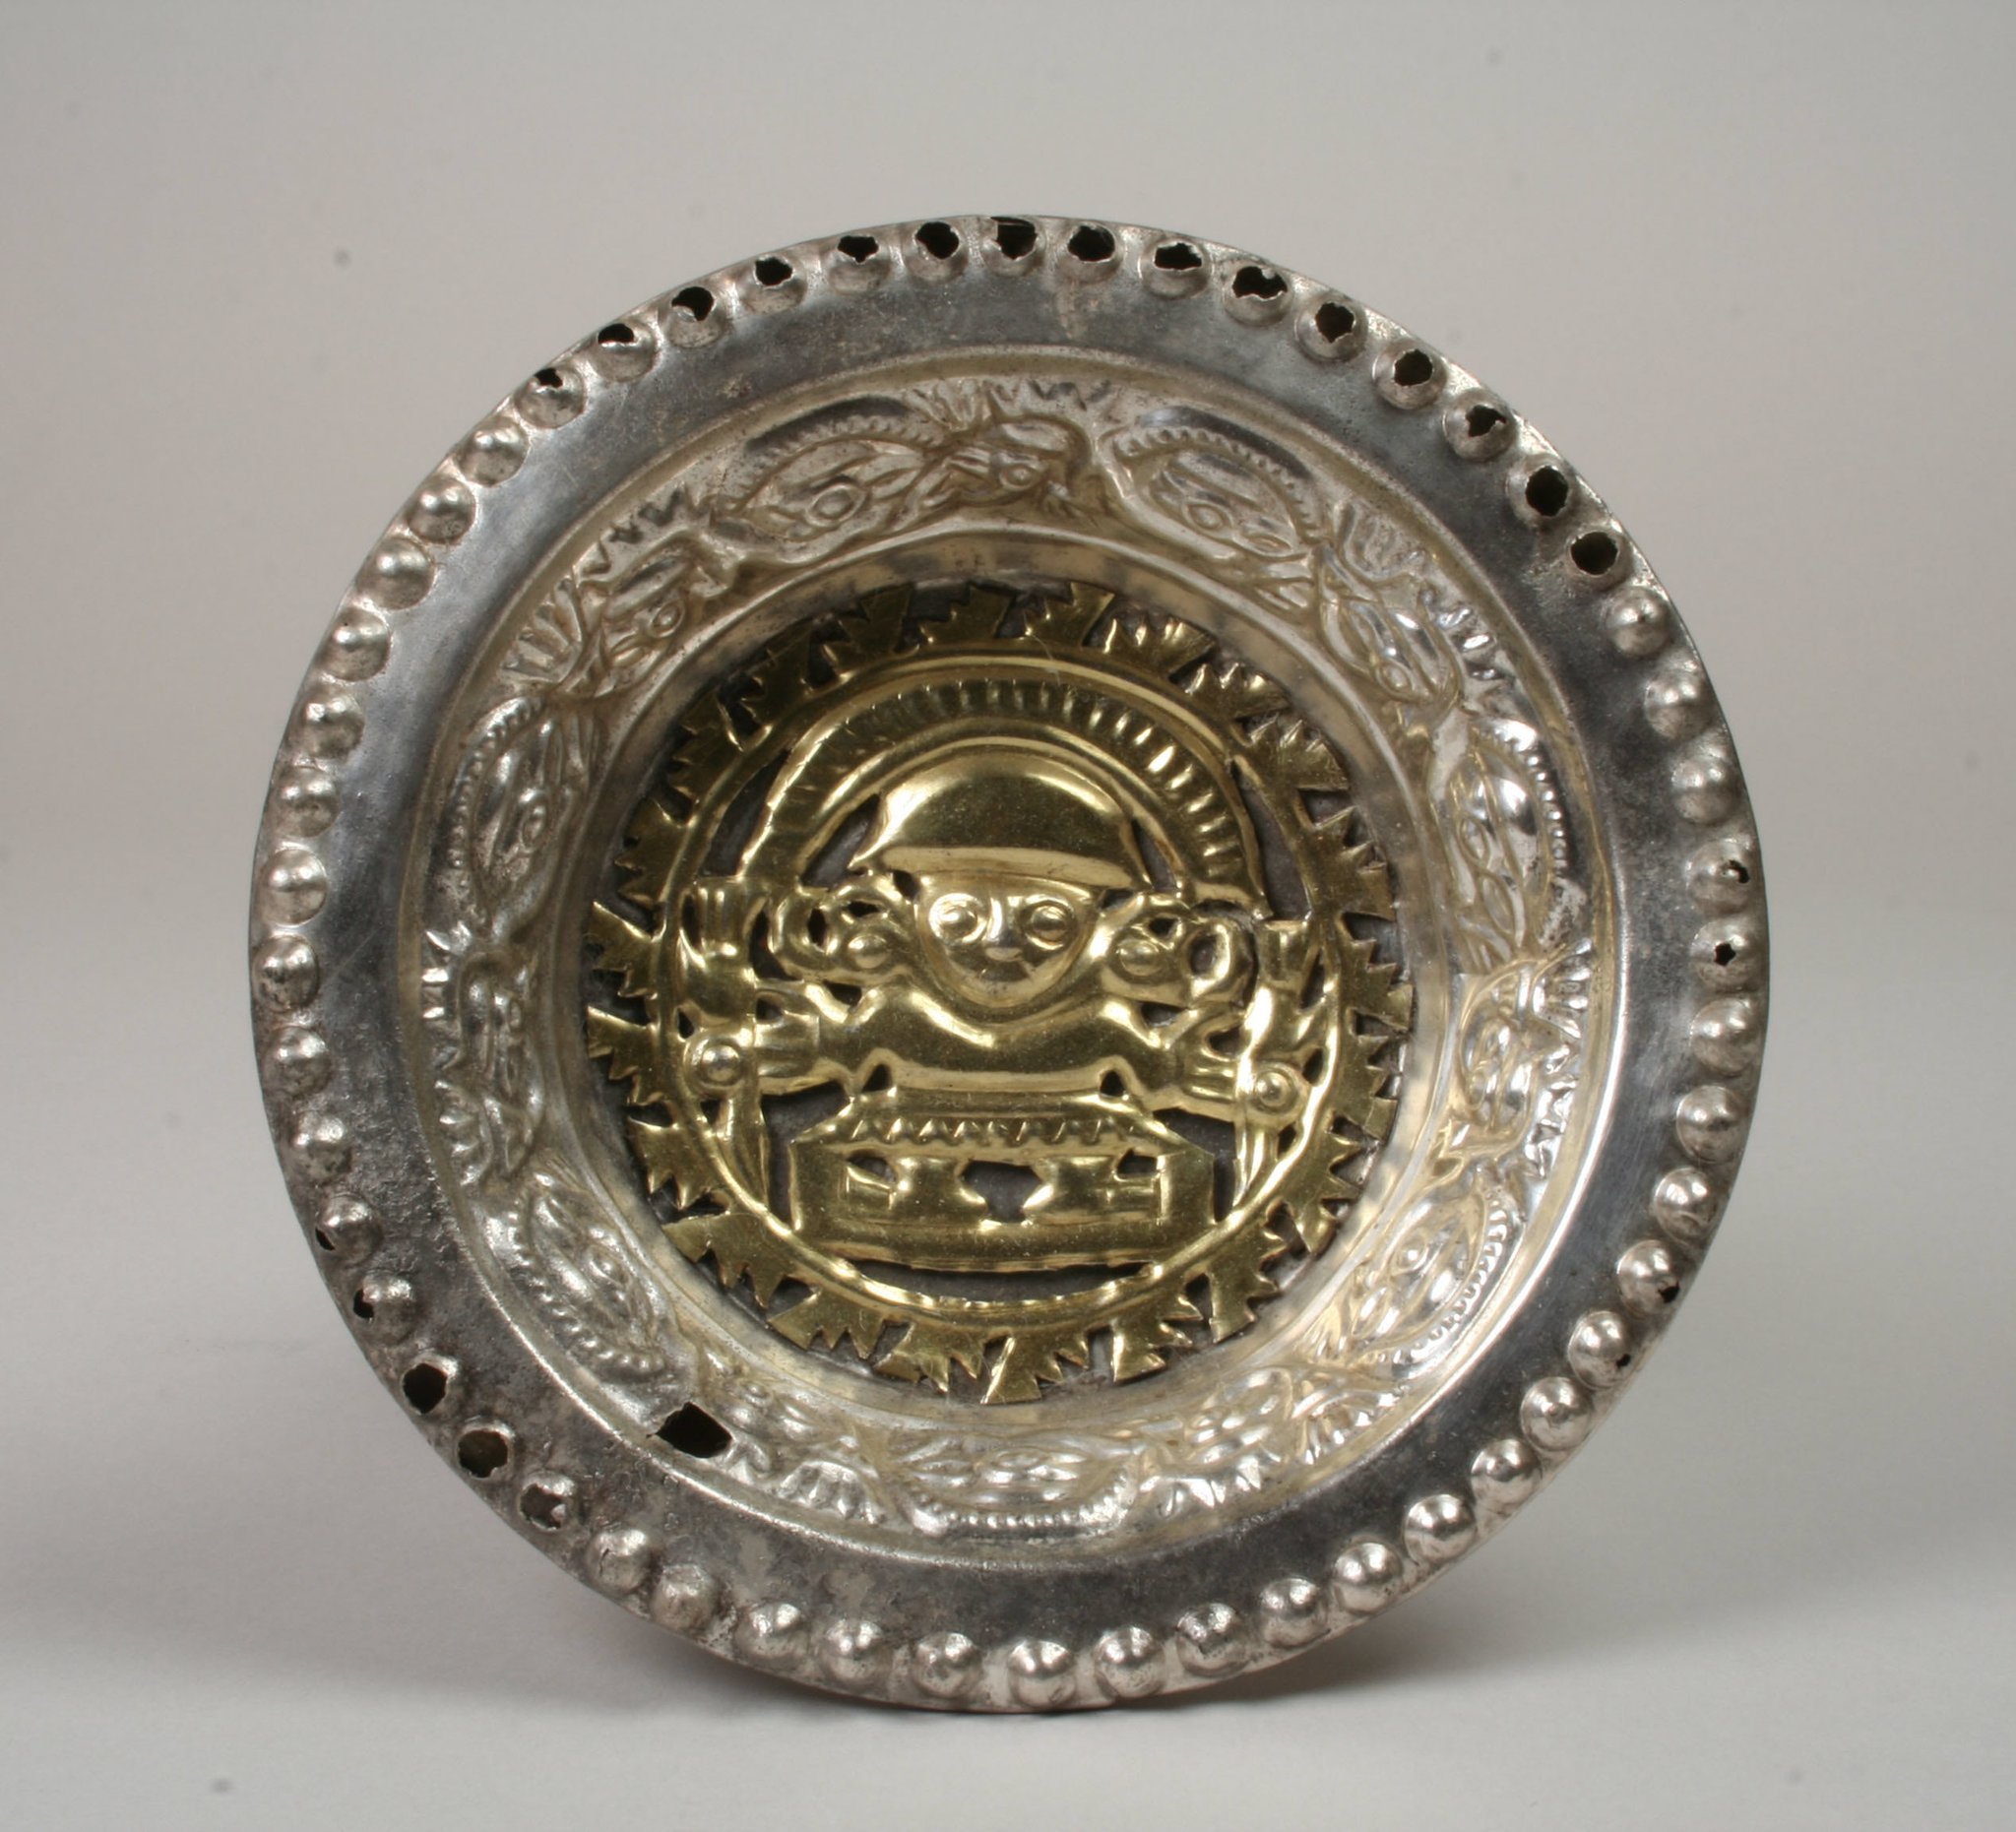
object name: earflare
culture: chimú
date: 1301-1500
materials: gold, silver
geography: peru